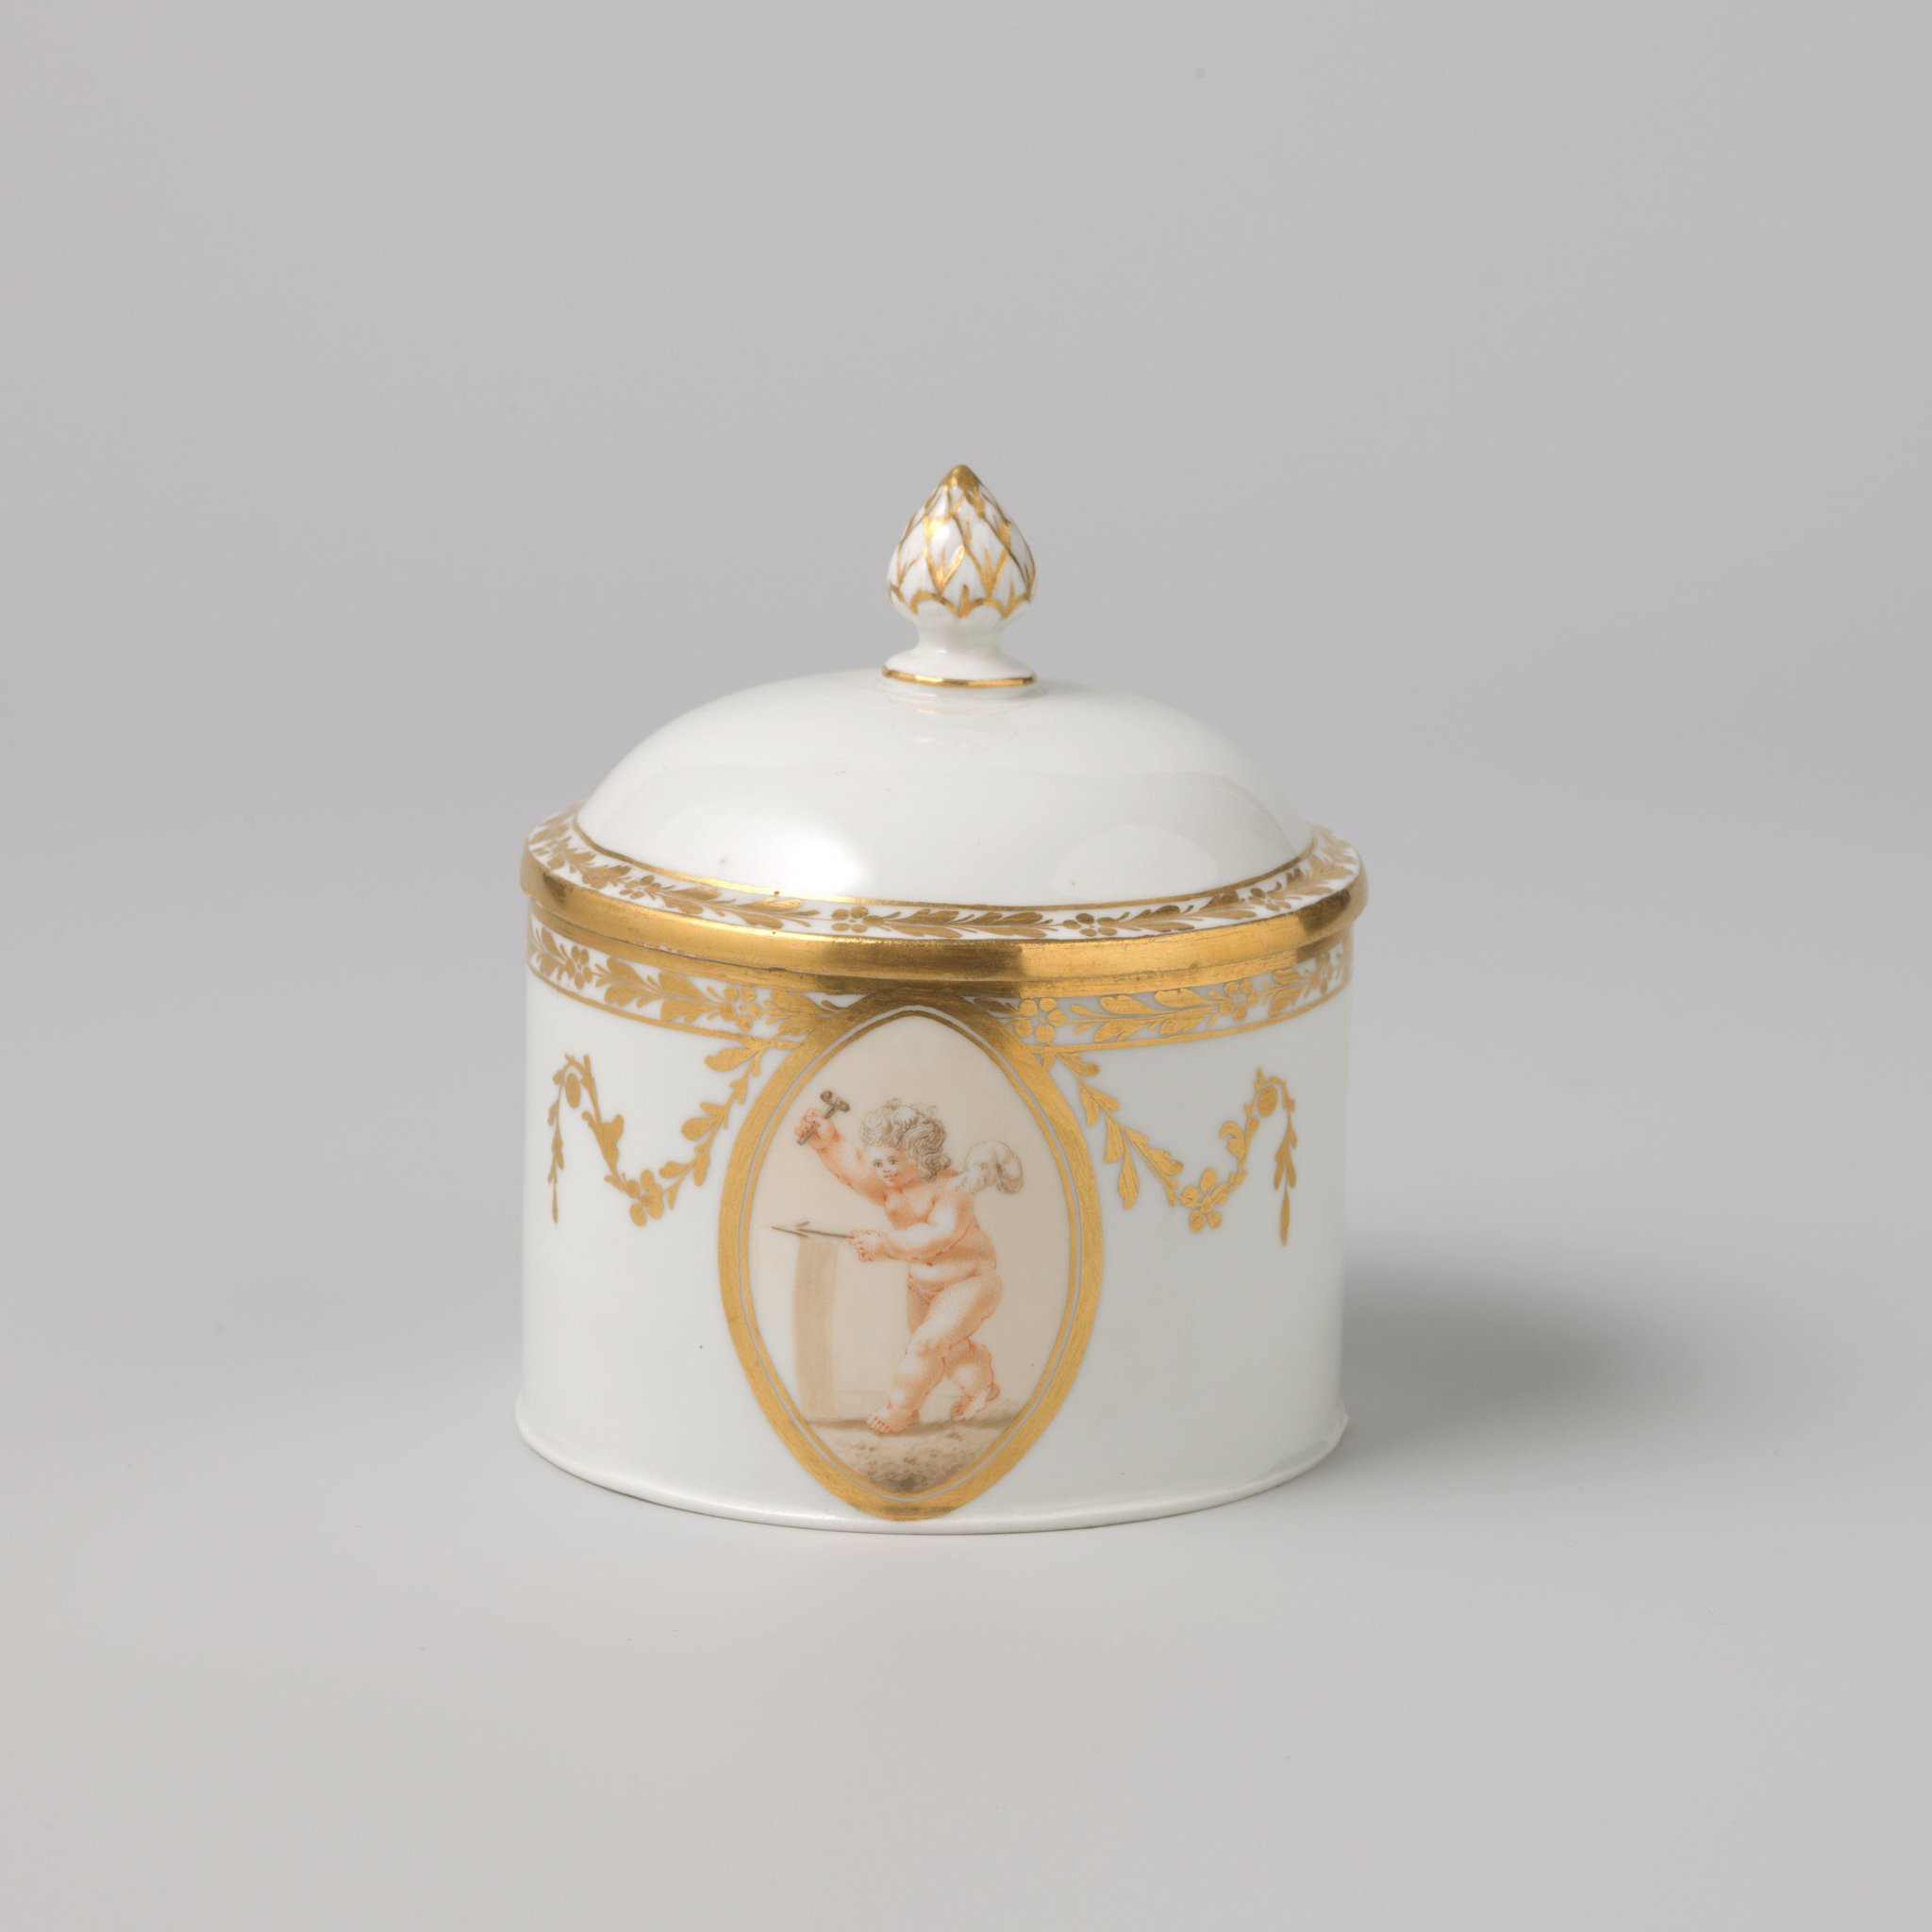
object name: service set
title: Cover of a sugar bowl with a foliate scroll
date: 1785-1795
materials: glaze, gold, paint, porcelain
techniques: firing, forming, gilding, turning, vitrification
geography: furstenberg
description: Deksel van een suikerpot van porselein, beschilderd op het glazuur in goud. Versierd met een bladrank en dekselknop in de vorm van een dennenappel.